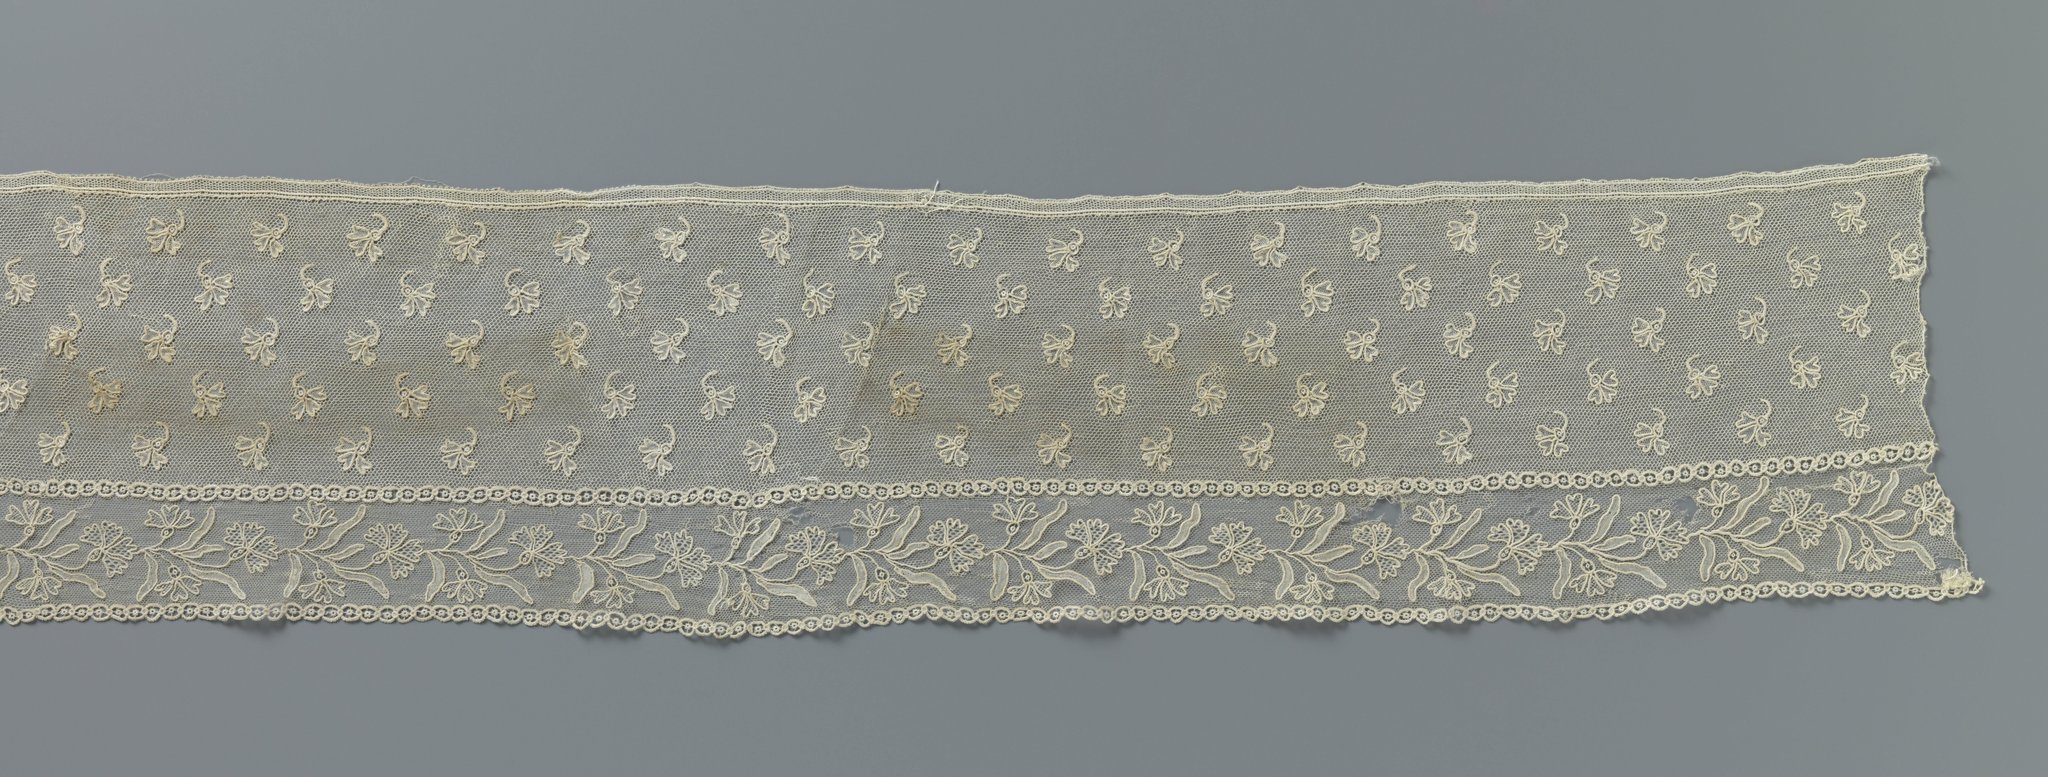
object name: strip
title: Strook naaldkant met korenbloemen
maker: Anonymous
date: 1800-1820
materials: linen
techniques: lace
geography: france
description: Tweederde van de breedte is gevuld met een strooipatroon van vallende korenbloempjes op een grof grond (van omwoelde spijlen). Een derde van de breedte vormt een recht afgesloten buitenrand (met een enkelvoudig Alençon-grond), omzoomd met twee parellijstjes, en versierd met een liggende rank van aaneengeregen stengeltjes, ieder met drie korenbloempjes, die steeds in dezelfde richting staan. Alençon-kant.